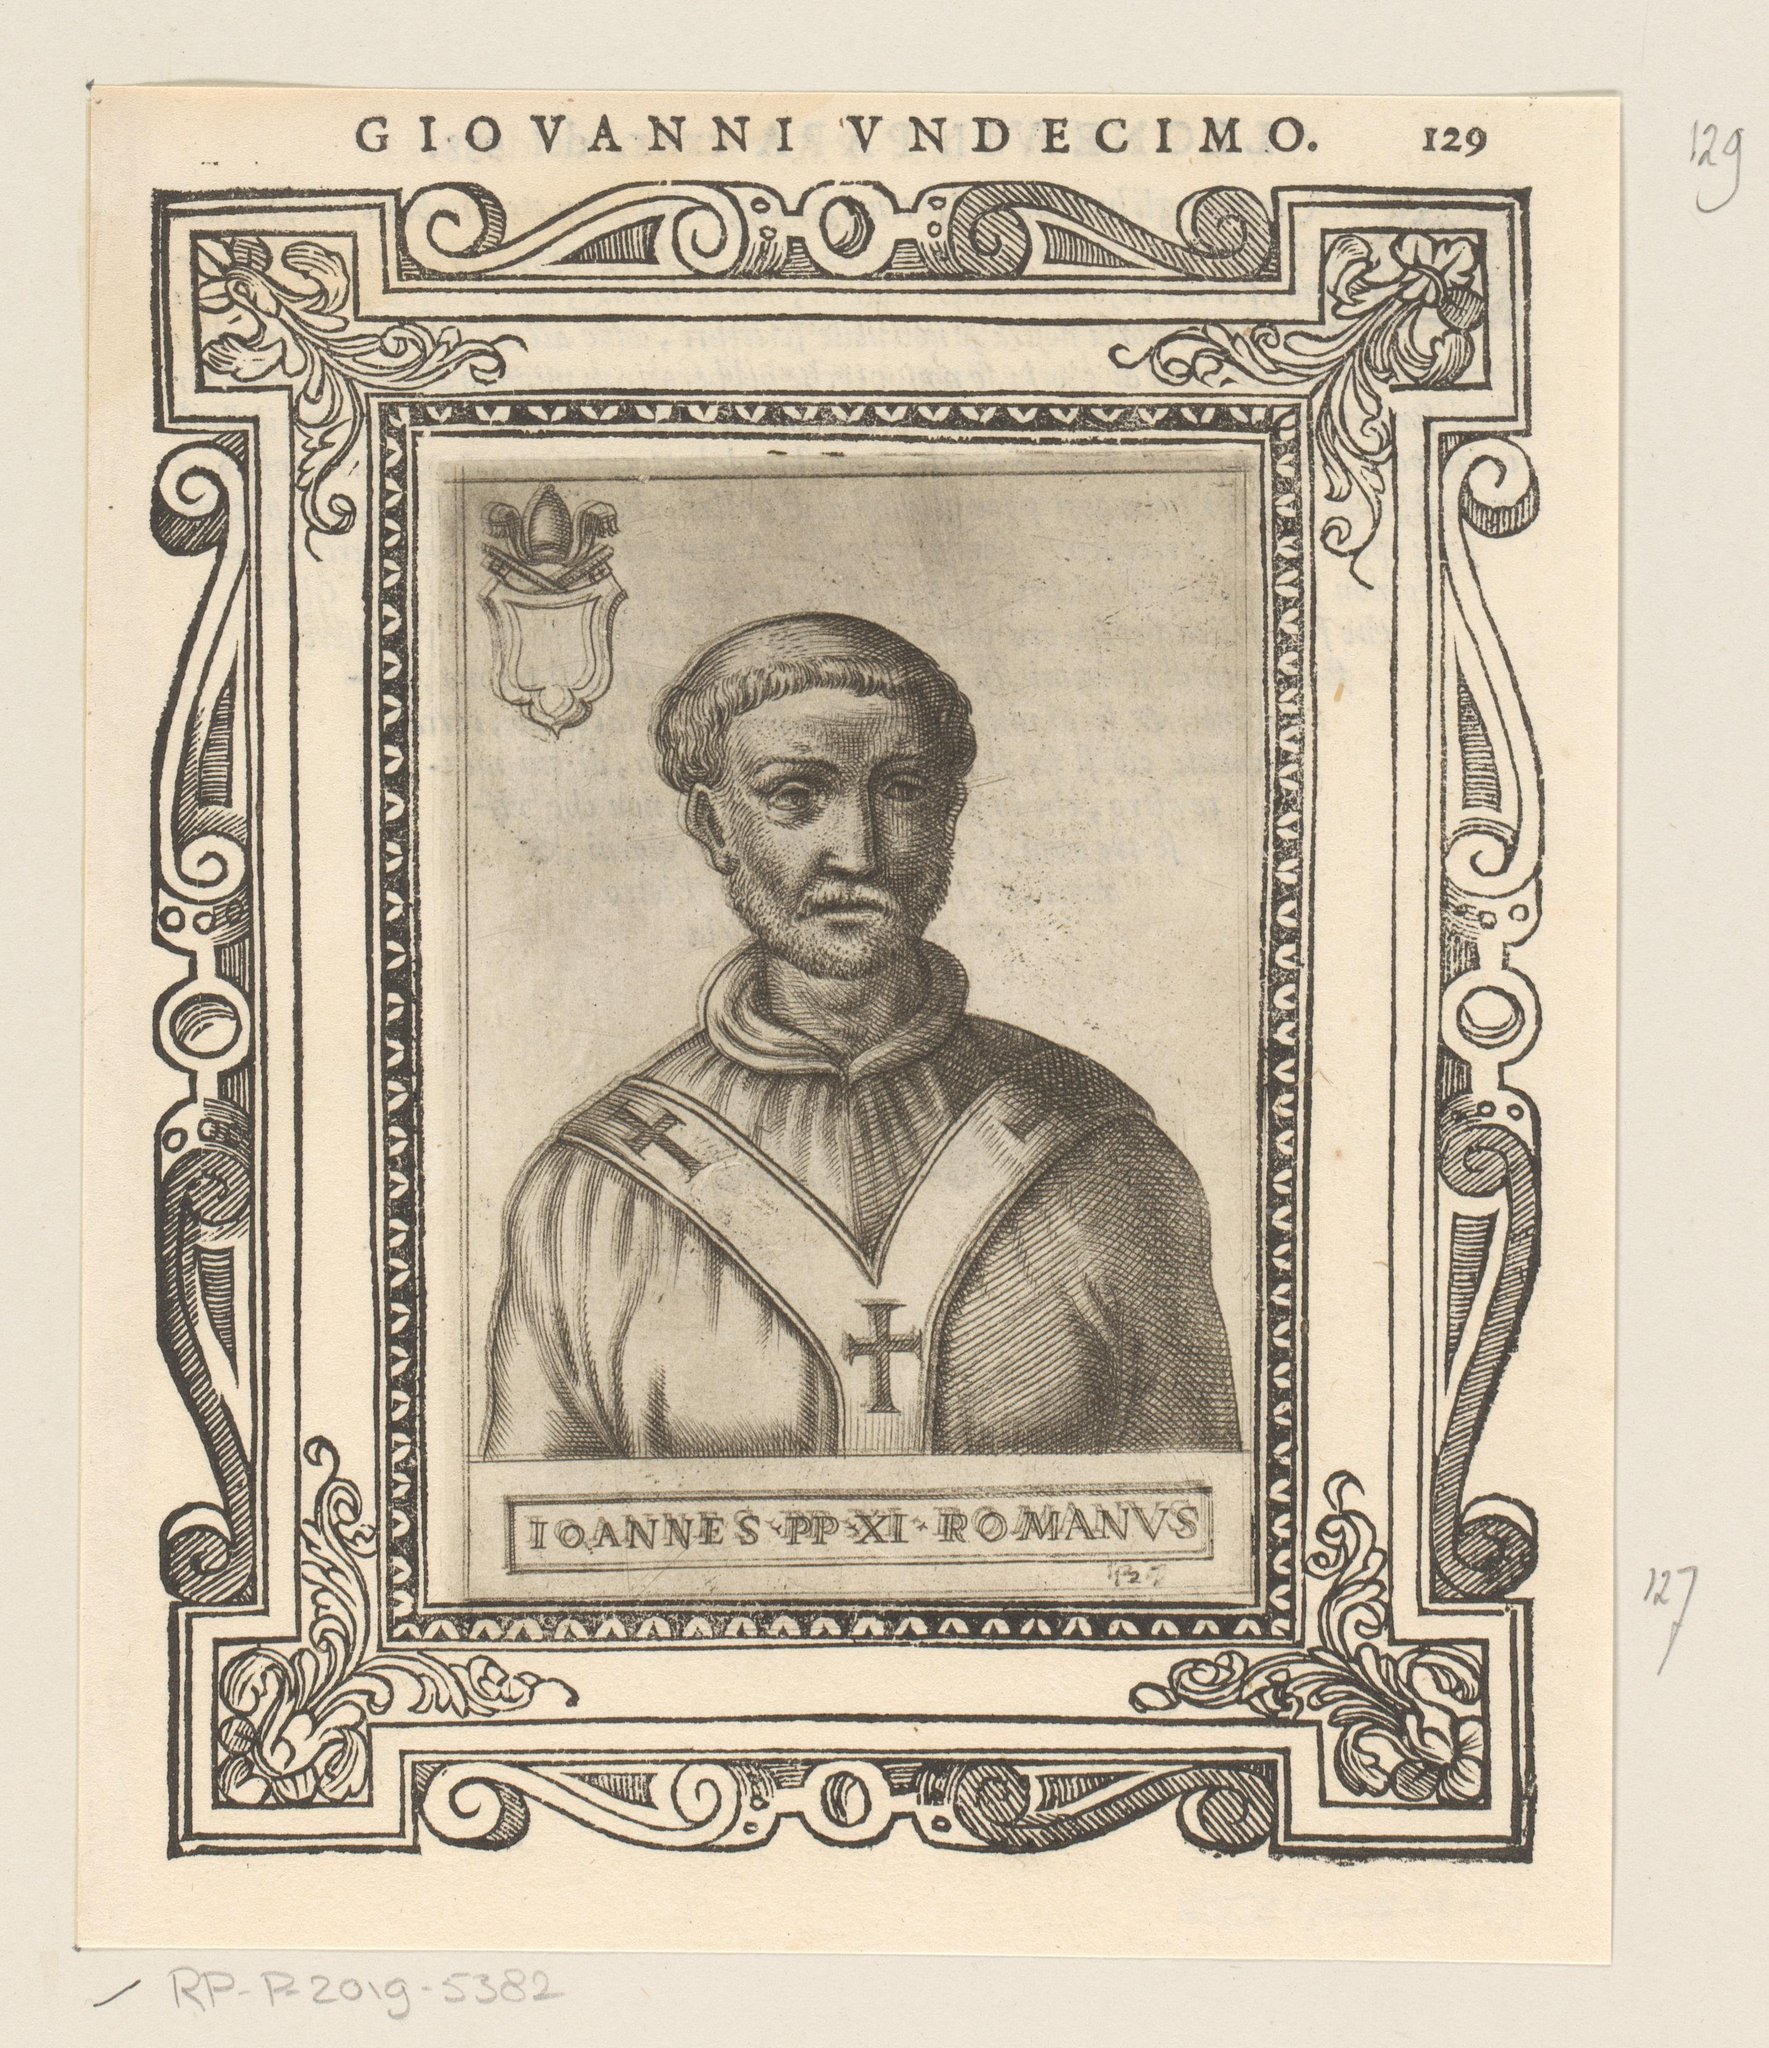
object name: print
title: Ioannes PP XI Romanus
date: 1587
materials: paper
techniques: engraving, letterpress printing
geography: rome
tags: historical persons, pope, armorial bearing, heraldry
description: Prent uit: Ciccarelli, Antonio. Le vite de Pontefici di Antonio Ciccarelli (...). Rome: Domenico Basa, 1587. Prent voor het eerst verschenen in: Cavalieri, Giovanni Battista de'. Pontificum romanorum effigies (...). Rome: Domenico Basa en Francesco Zanetti, 1580. Prent ook gebruikt in latere publicaties.